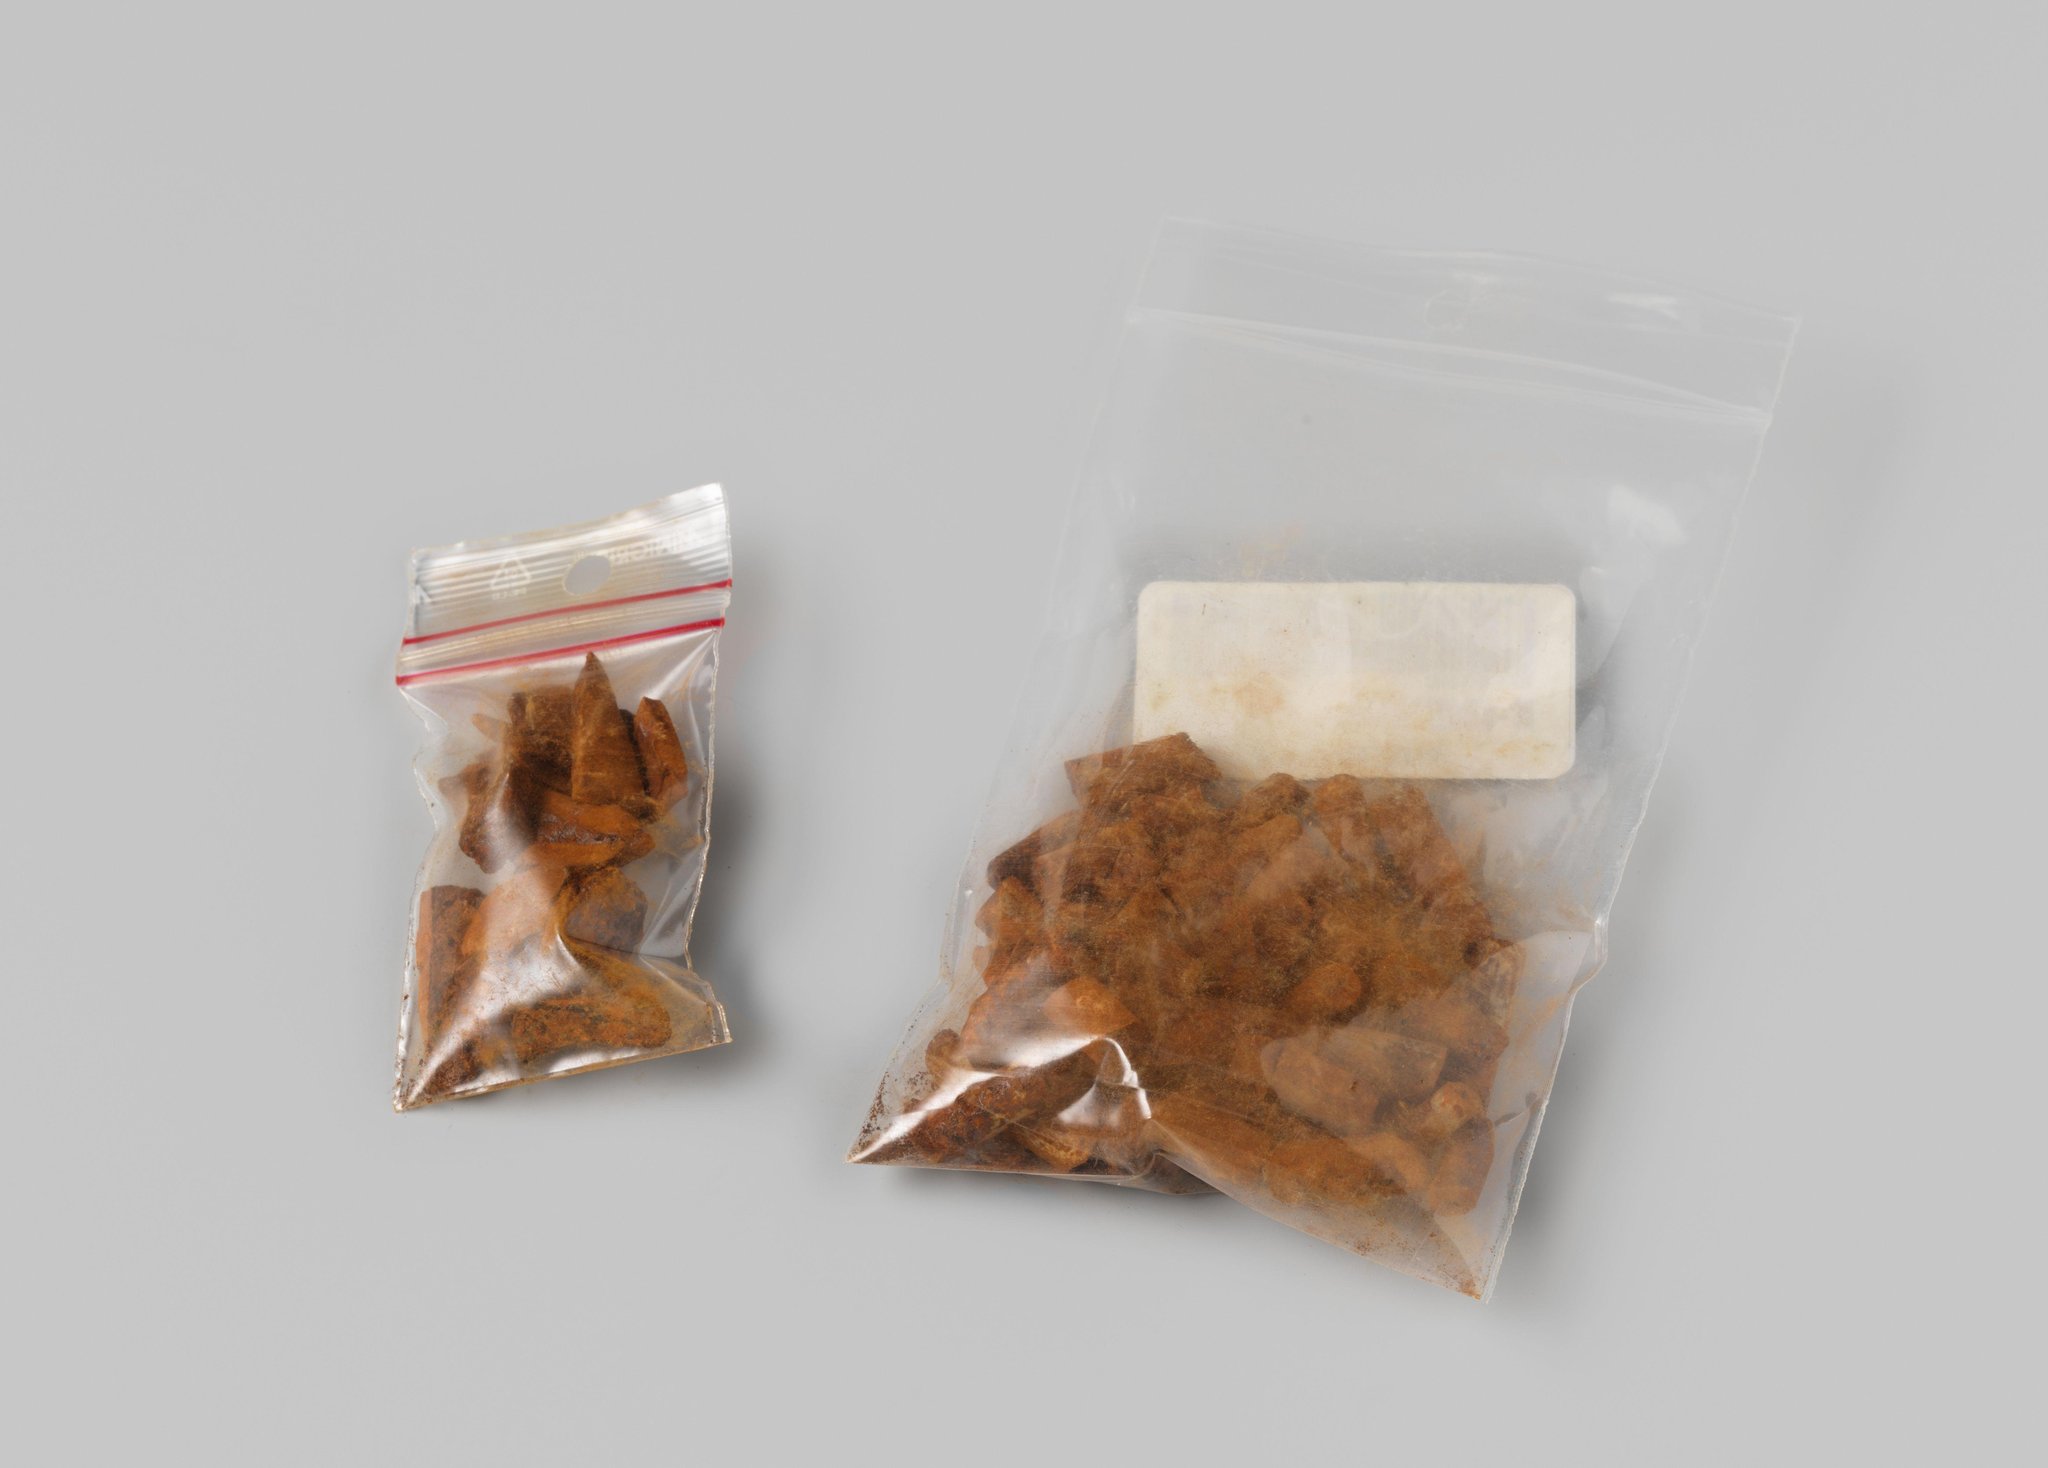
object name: pipe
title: Fragmenten pijpensteel en pijpenkop uit het wrak van de Oostindiëvaarder Hollandia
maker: Anonymous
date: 1700-1743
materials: clay